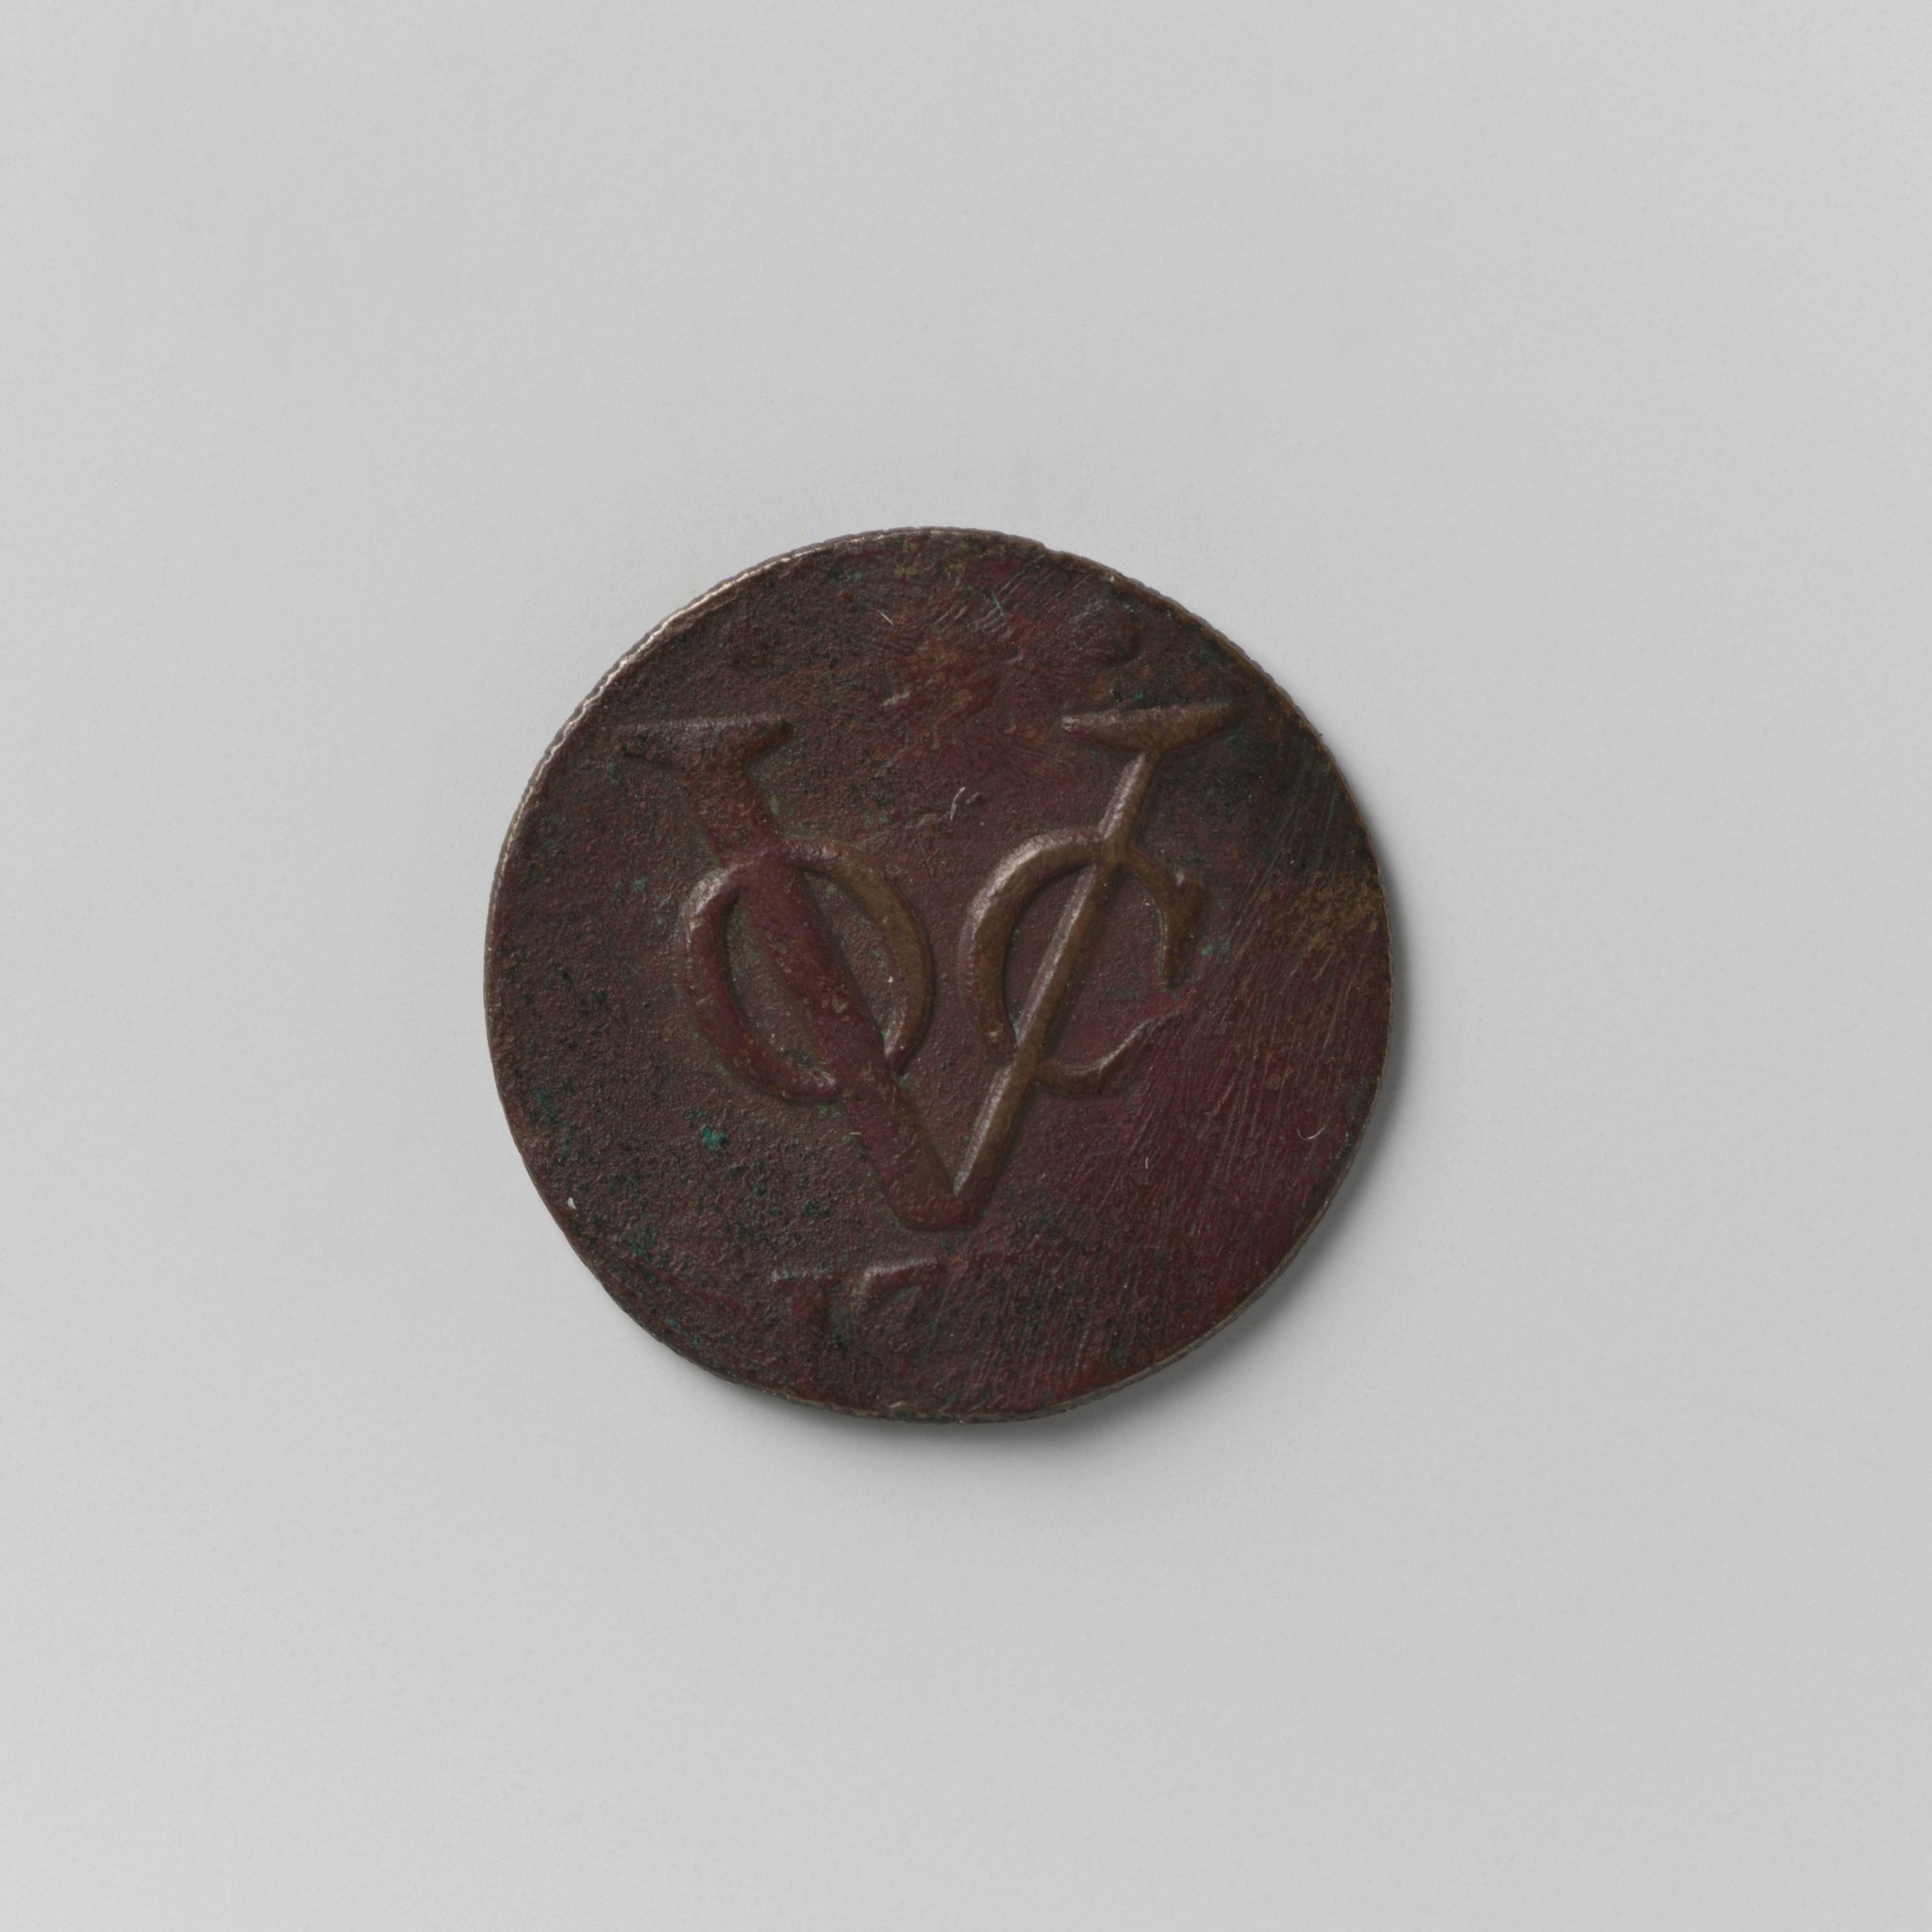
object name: coin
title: VOC, valse duit Overijssel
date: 1700-1799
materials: copper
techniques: striking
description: Valse koperen munt. Voorzijde: tussen wapenspreuk gekroond provinciaal wapenschild. Keerzijde: monogram van de VOC, waaronder eerste gedeelte van jaartal. Vervalsing. Zie opmerking in Catalogus Stephanik bij dit nummer.